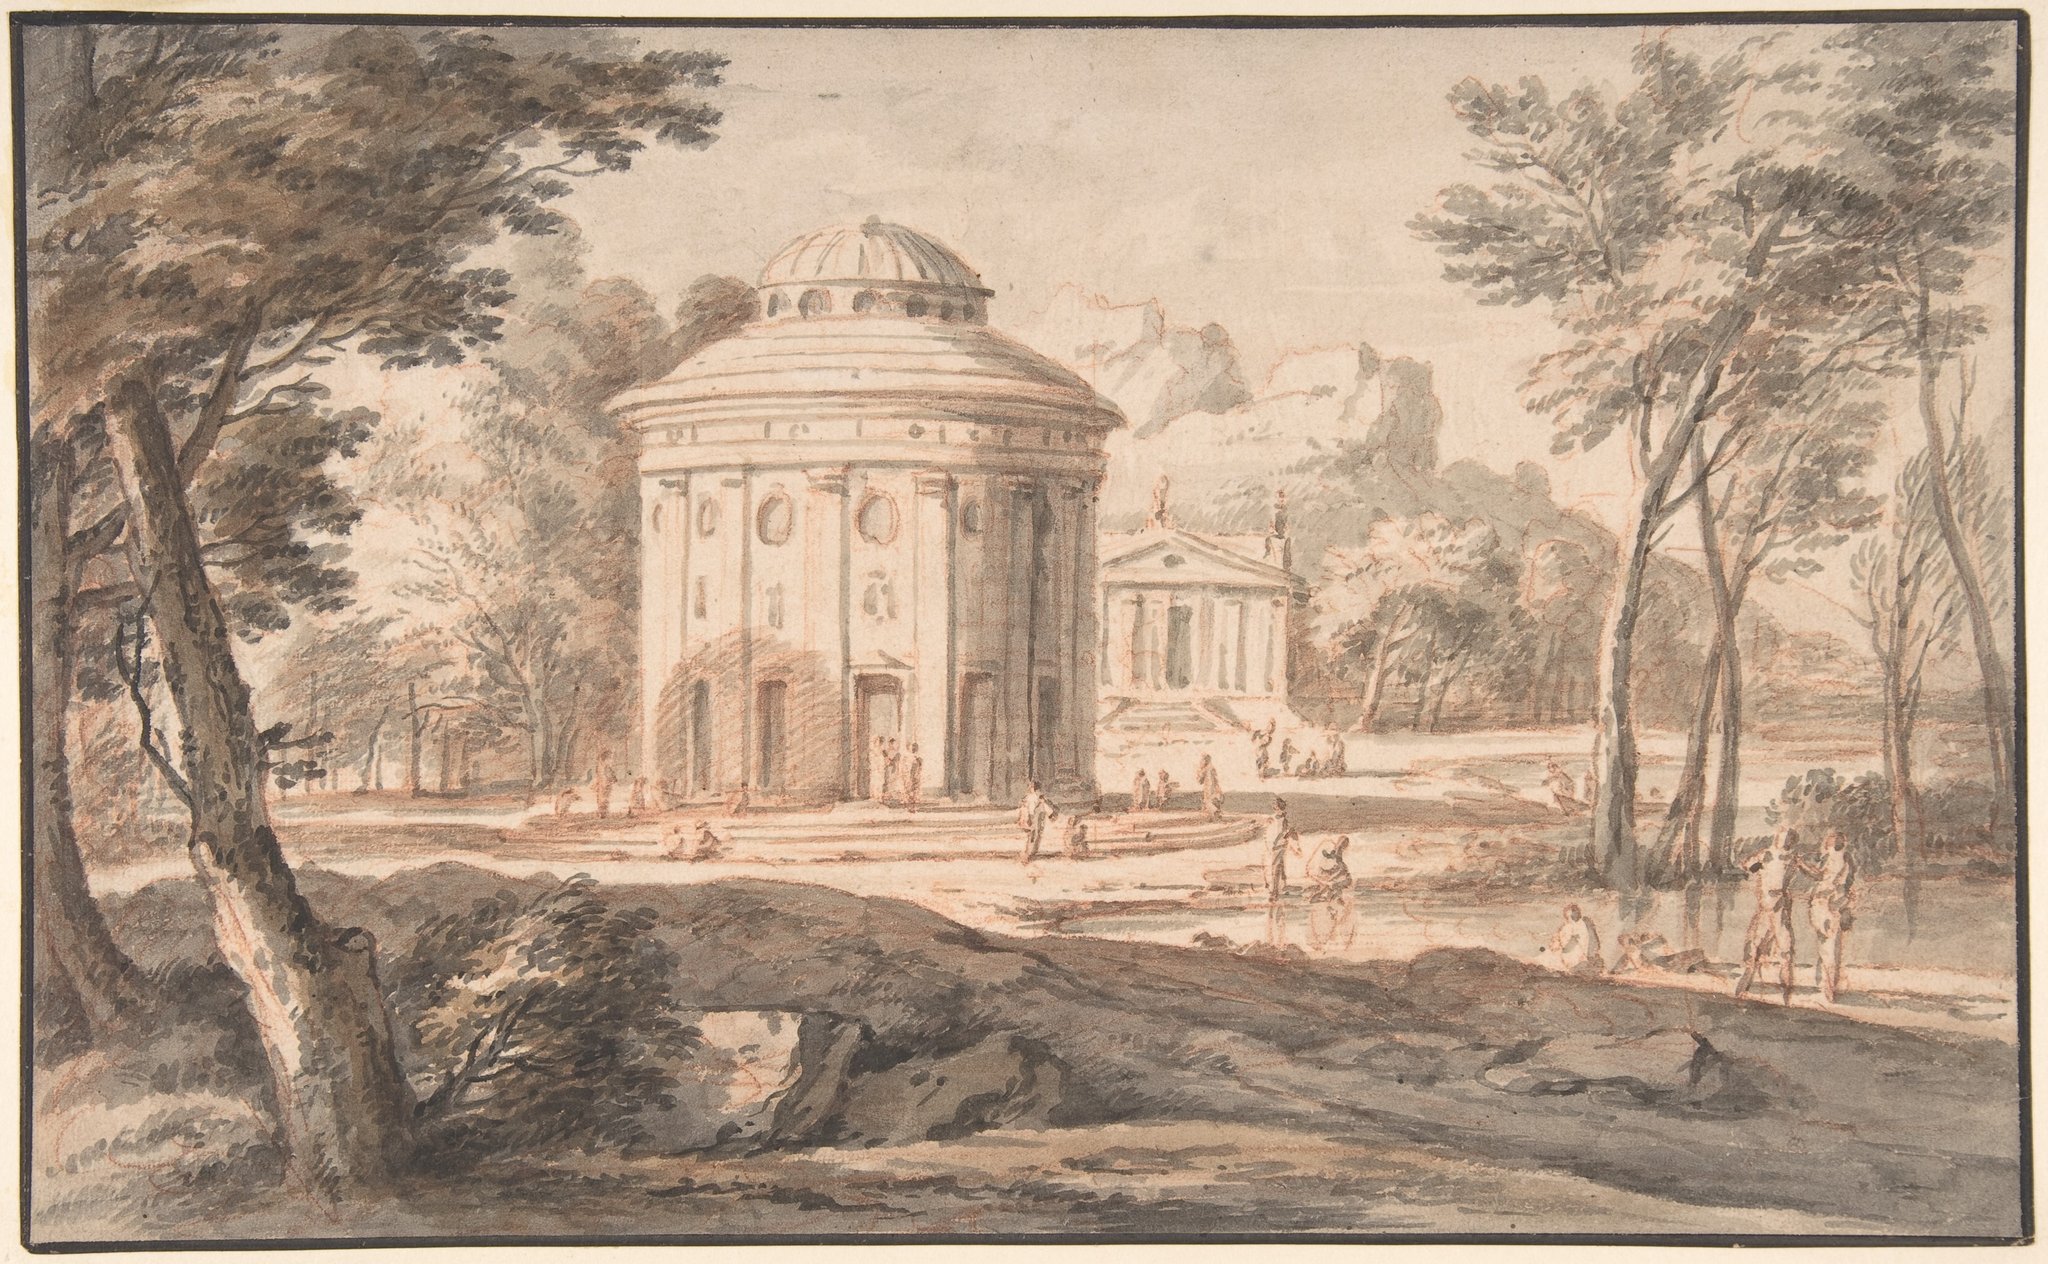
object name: drawing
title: Landscape with Two Classical Temples and Figures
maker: jan frans van bloemen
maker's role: artist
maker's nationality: flemish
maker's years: 1662-1749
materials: chalk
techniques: brush, wash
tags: temples,landscapes,trees